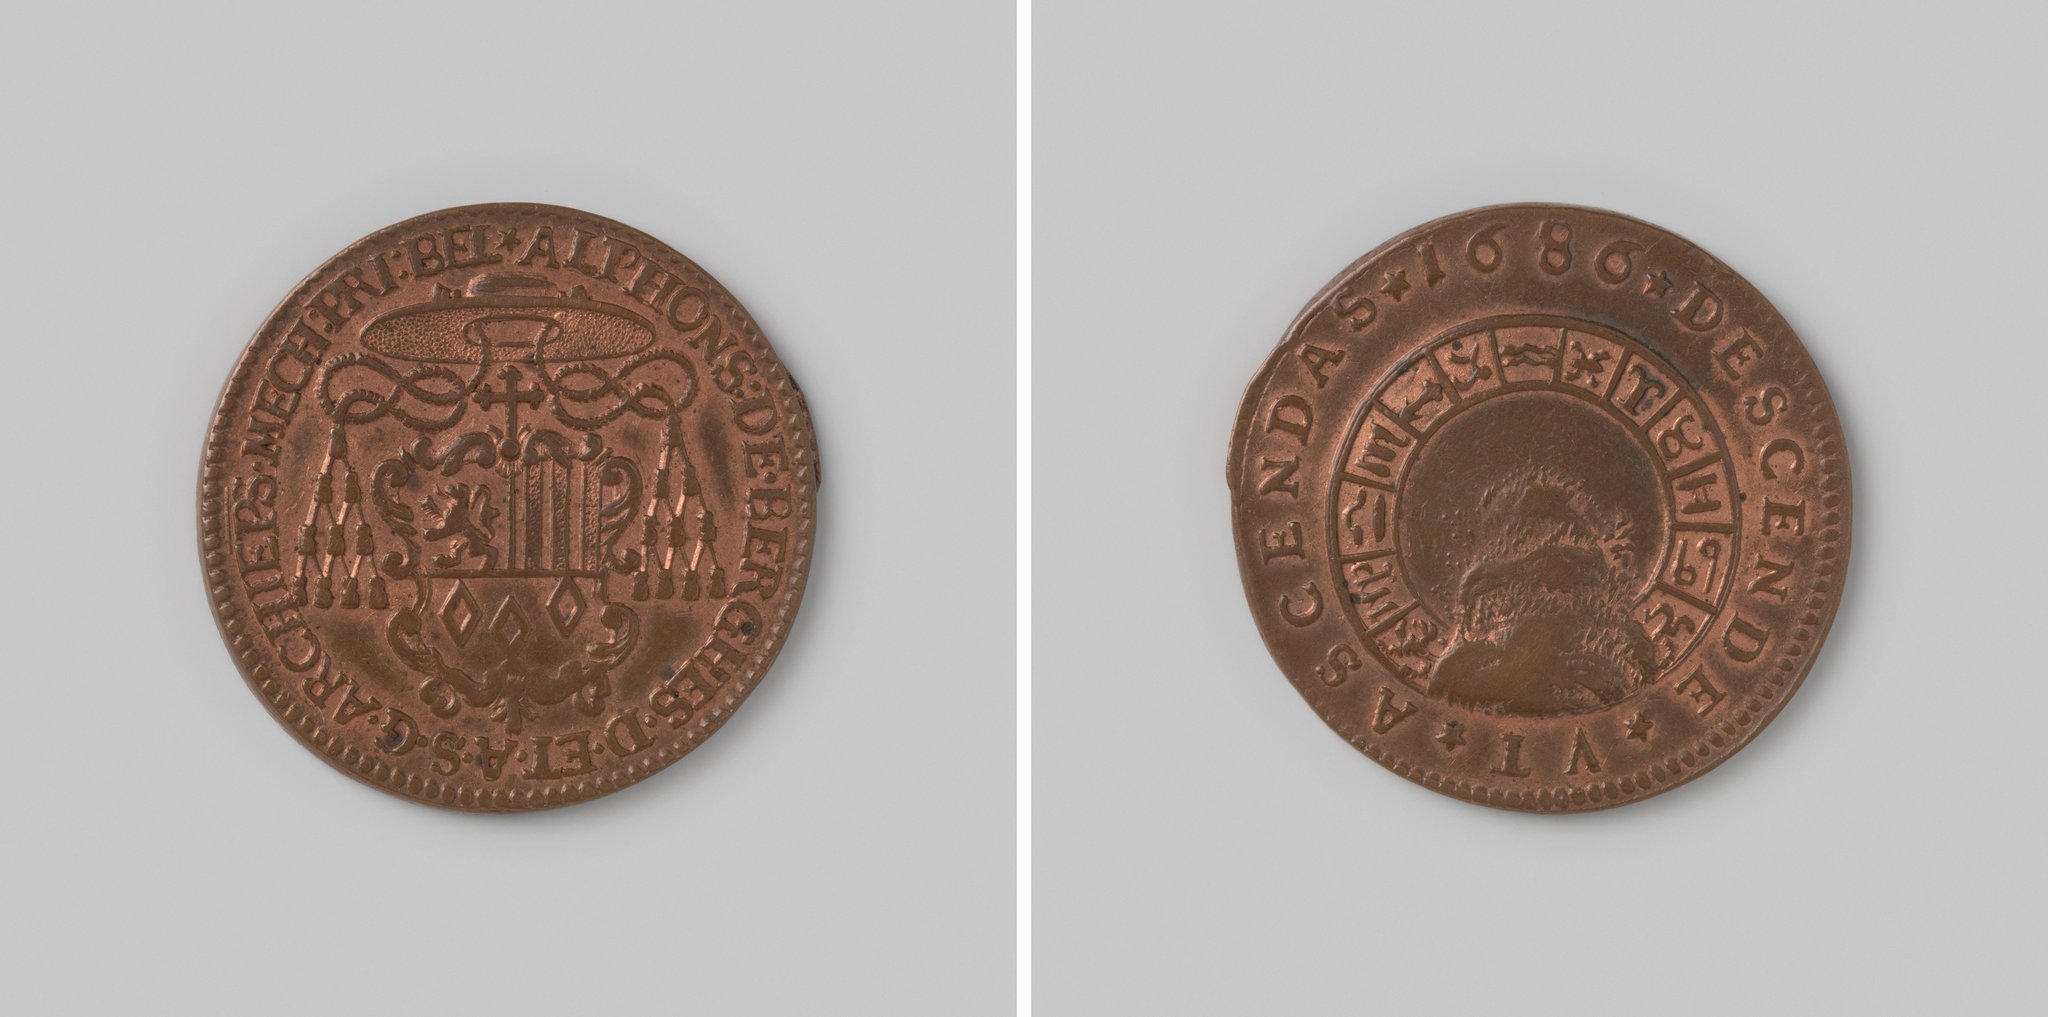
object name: jeton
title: Rekenpenning voor Alphons van Bergen Aartsbisschop van Mechelen 1686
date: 1686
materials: copper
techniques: striking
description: Koperen penning, op de voorzijde een wapenschild onder een kardinaalshoed, met omschrift, op de keerzijde een berg in het midden van de dierenriem, met omschrift.